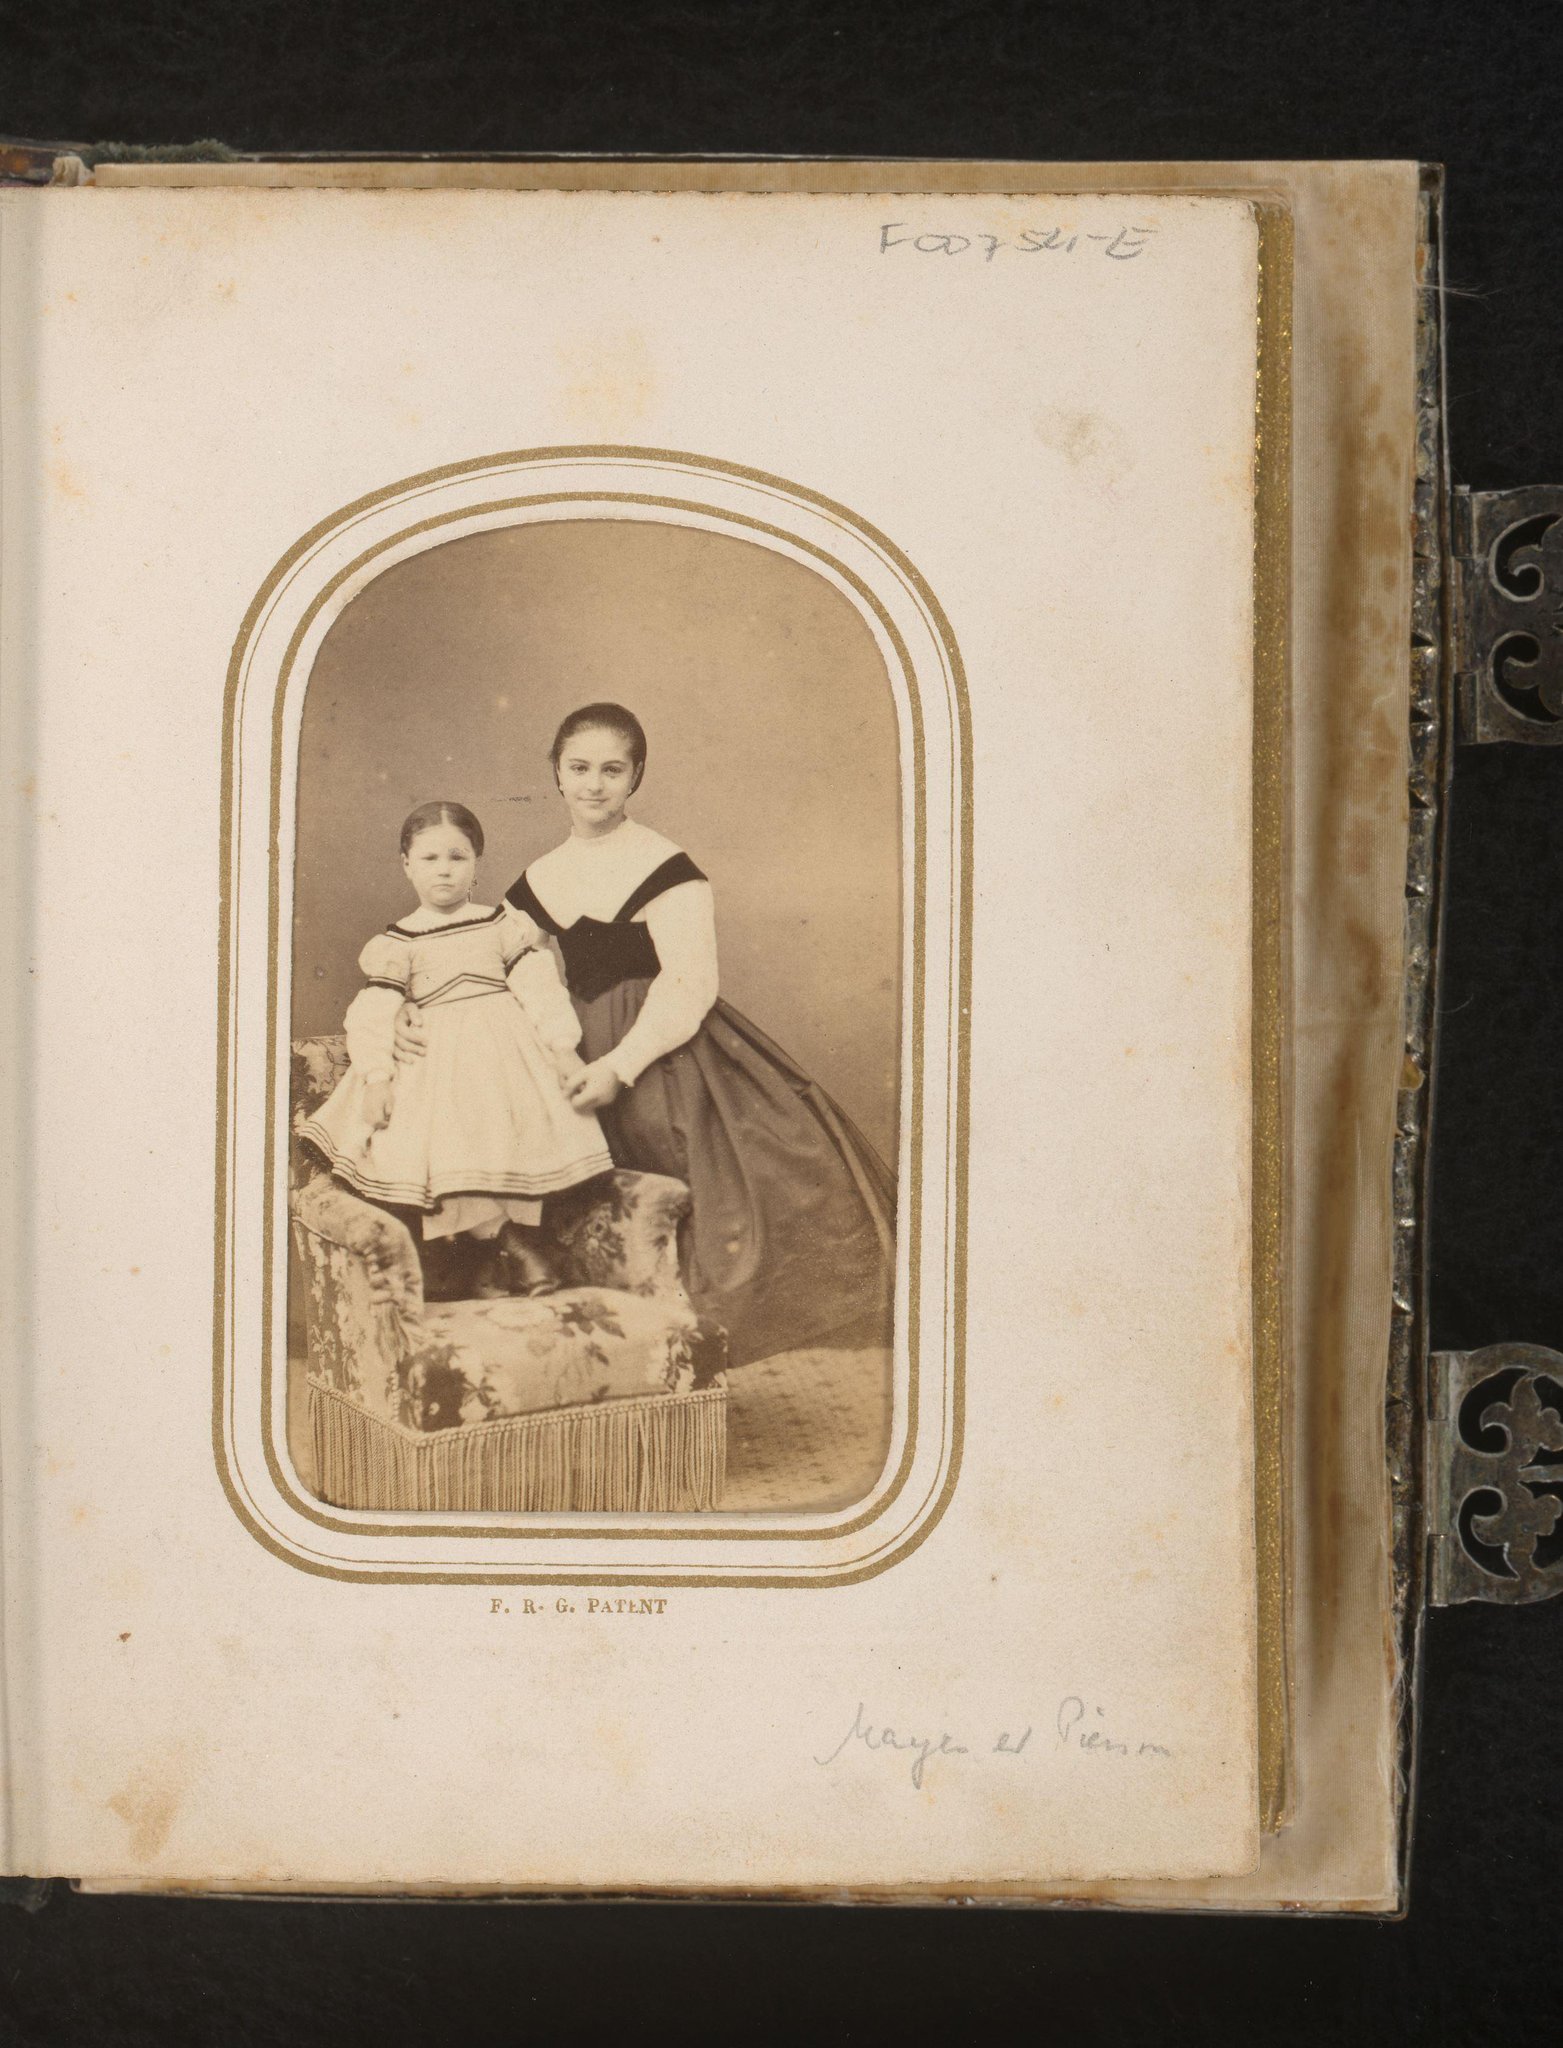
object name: album leaf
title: Portret van twee meisjes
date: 1855-1878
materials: cardboard, photographic support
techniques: albumen print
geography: paris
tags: girl (child between toddler and youth)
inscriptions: inscription: ‘Paris, Boulevart des Capucines 3’, annotation: ‘Mayer & Pierson’